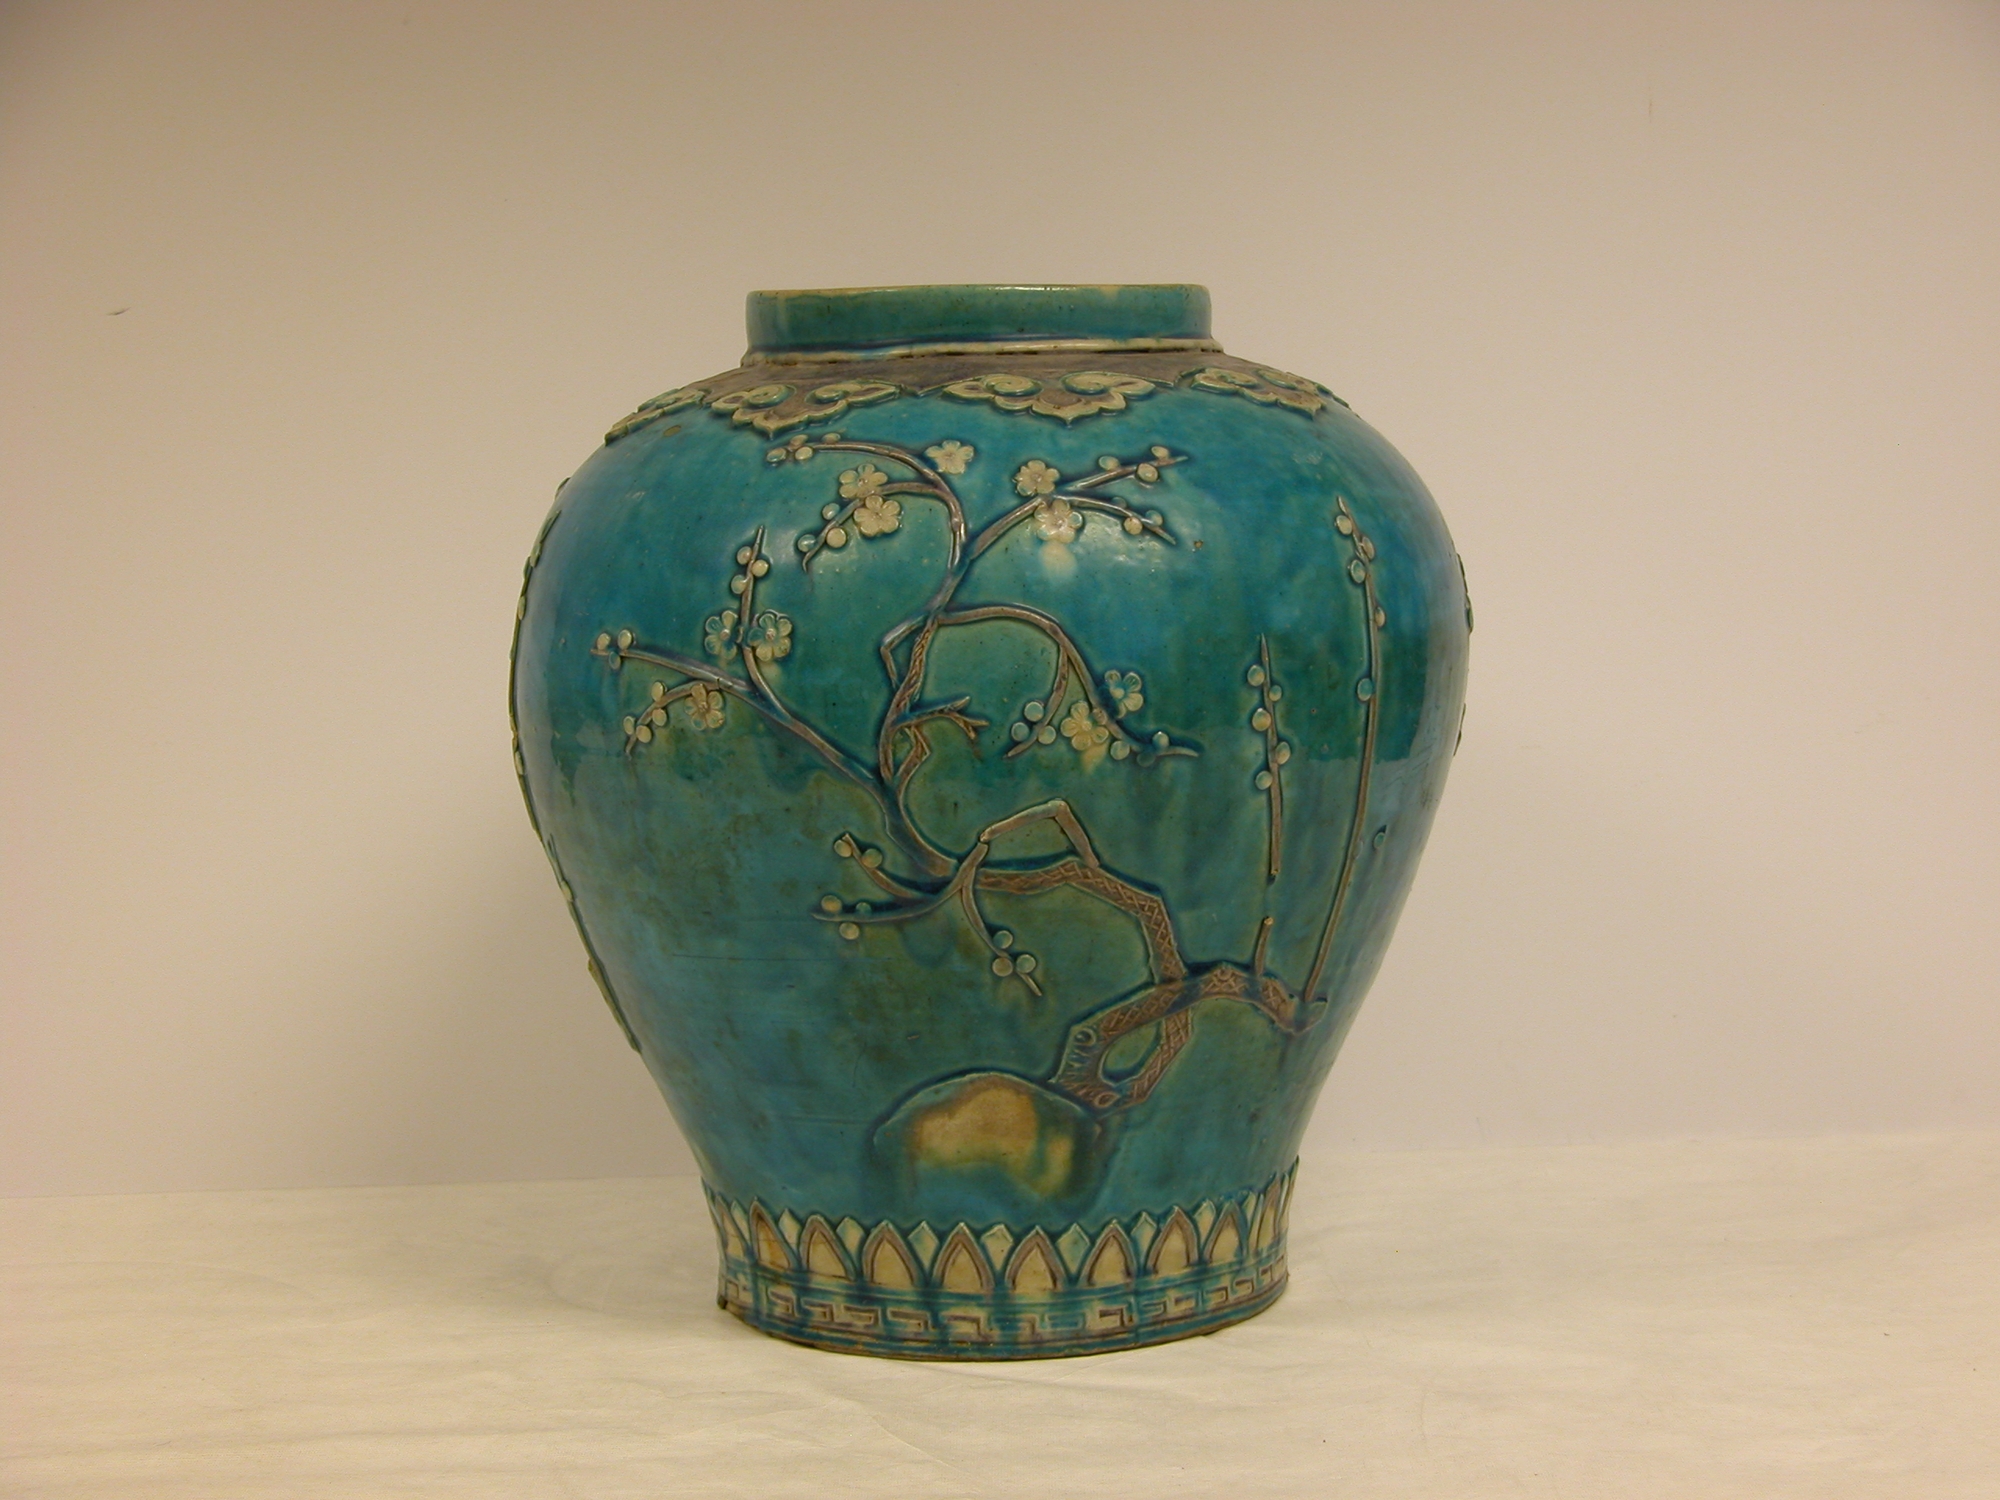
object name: jar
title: Jar decorated with plum blossoms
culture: chinese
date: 1501-1533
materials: glaze, stoneware